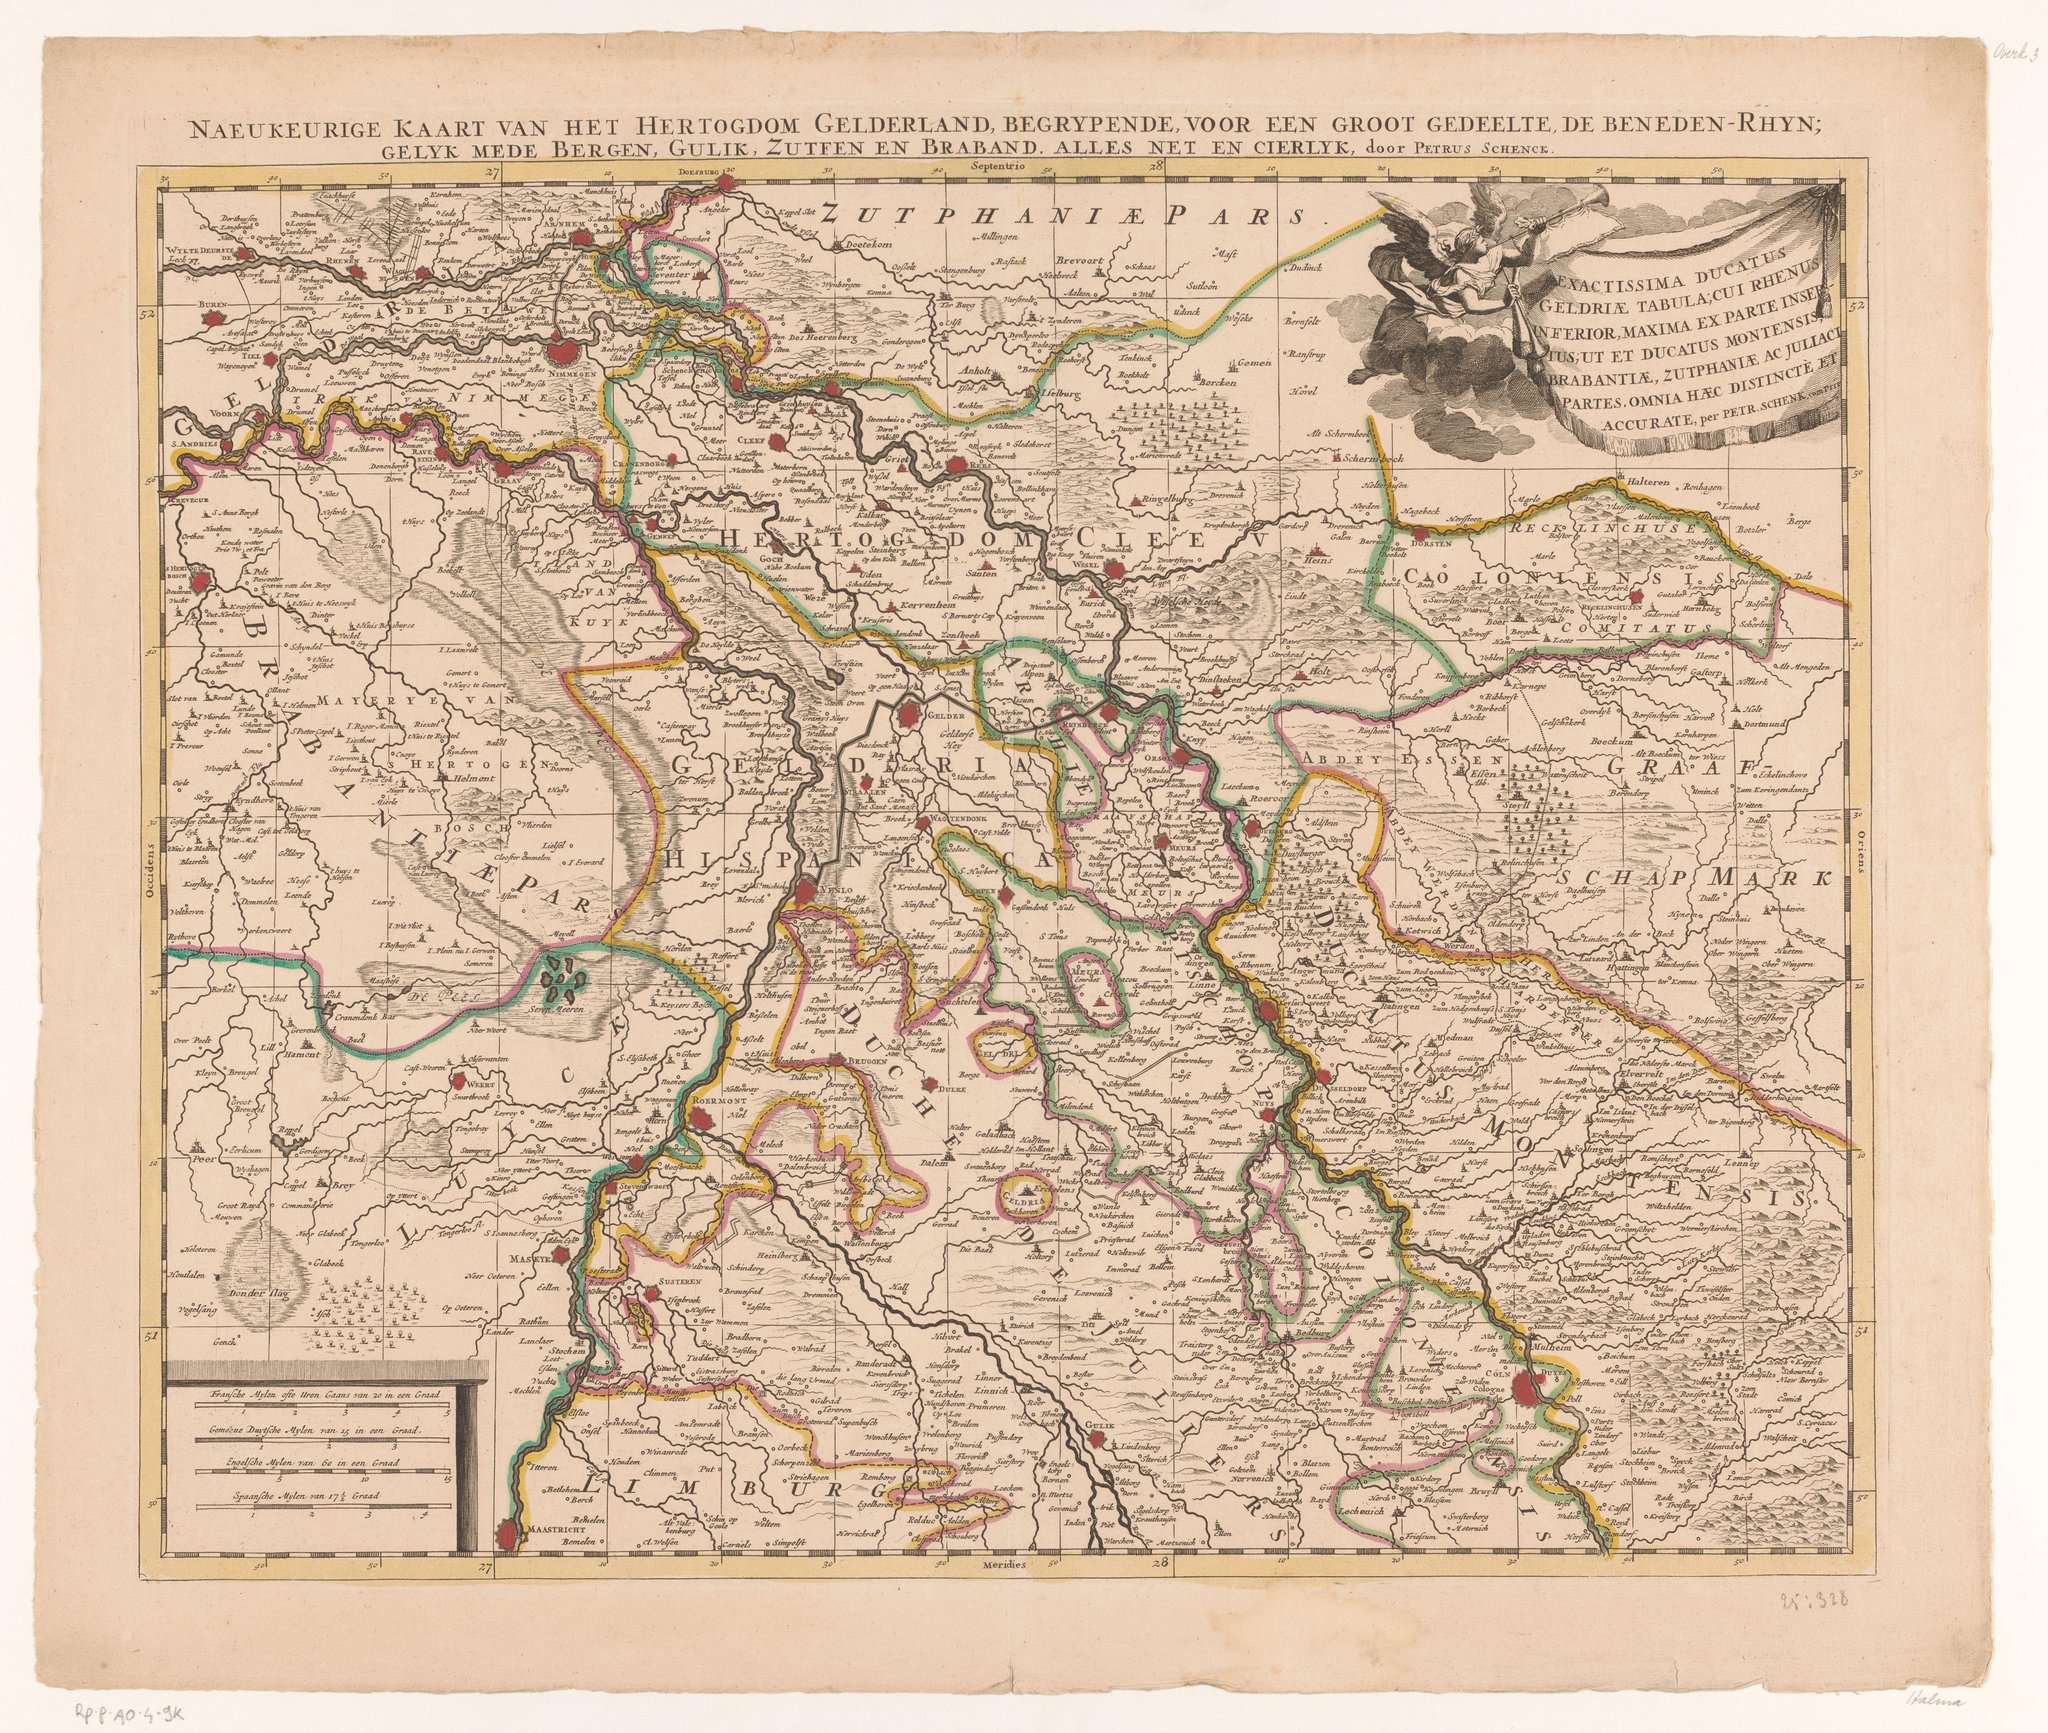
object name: map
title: Kaart van Gelderland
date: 1695-1711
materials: paper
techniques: engraving, etching, hand coloring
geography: amsterdam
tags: maps of separate countries or regions, gelderland, guelders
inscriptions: collector's mark: Lugt 2228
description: Rechtsboven de titelcartouche. Boven de kaart een tweede titel. Linksonder een cartouche met vier schaalstokken. De kaart is voorzien van een zoekrooster en een gradenverdeling langs de randen.